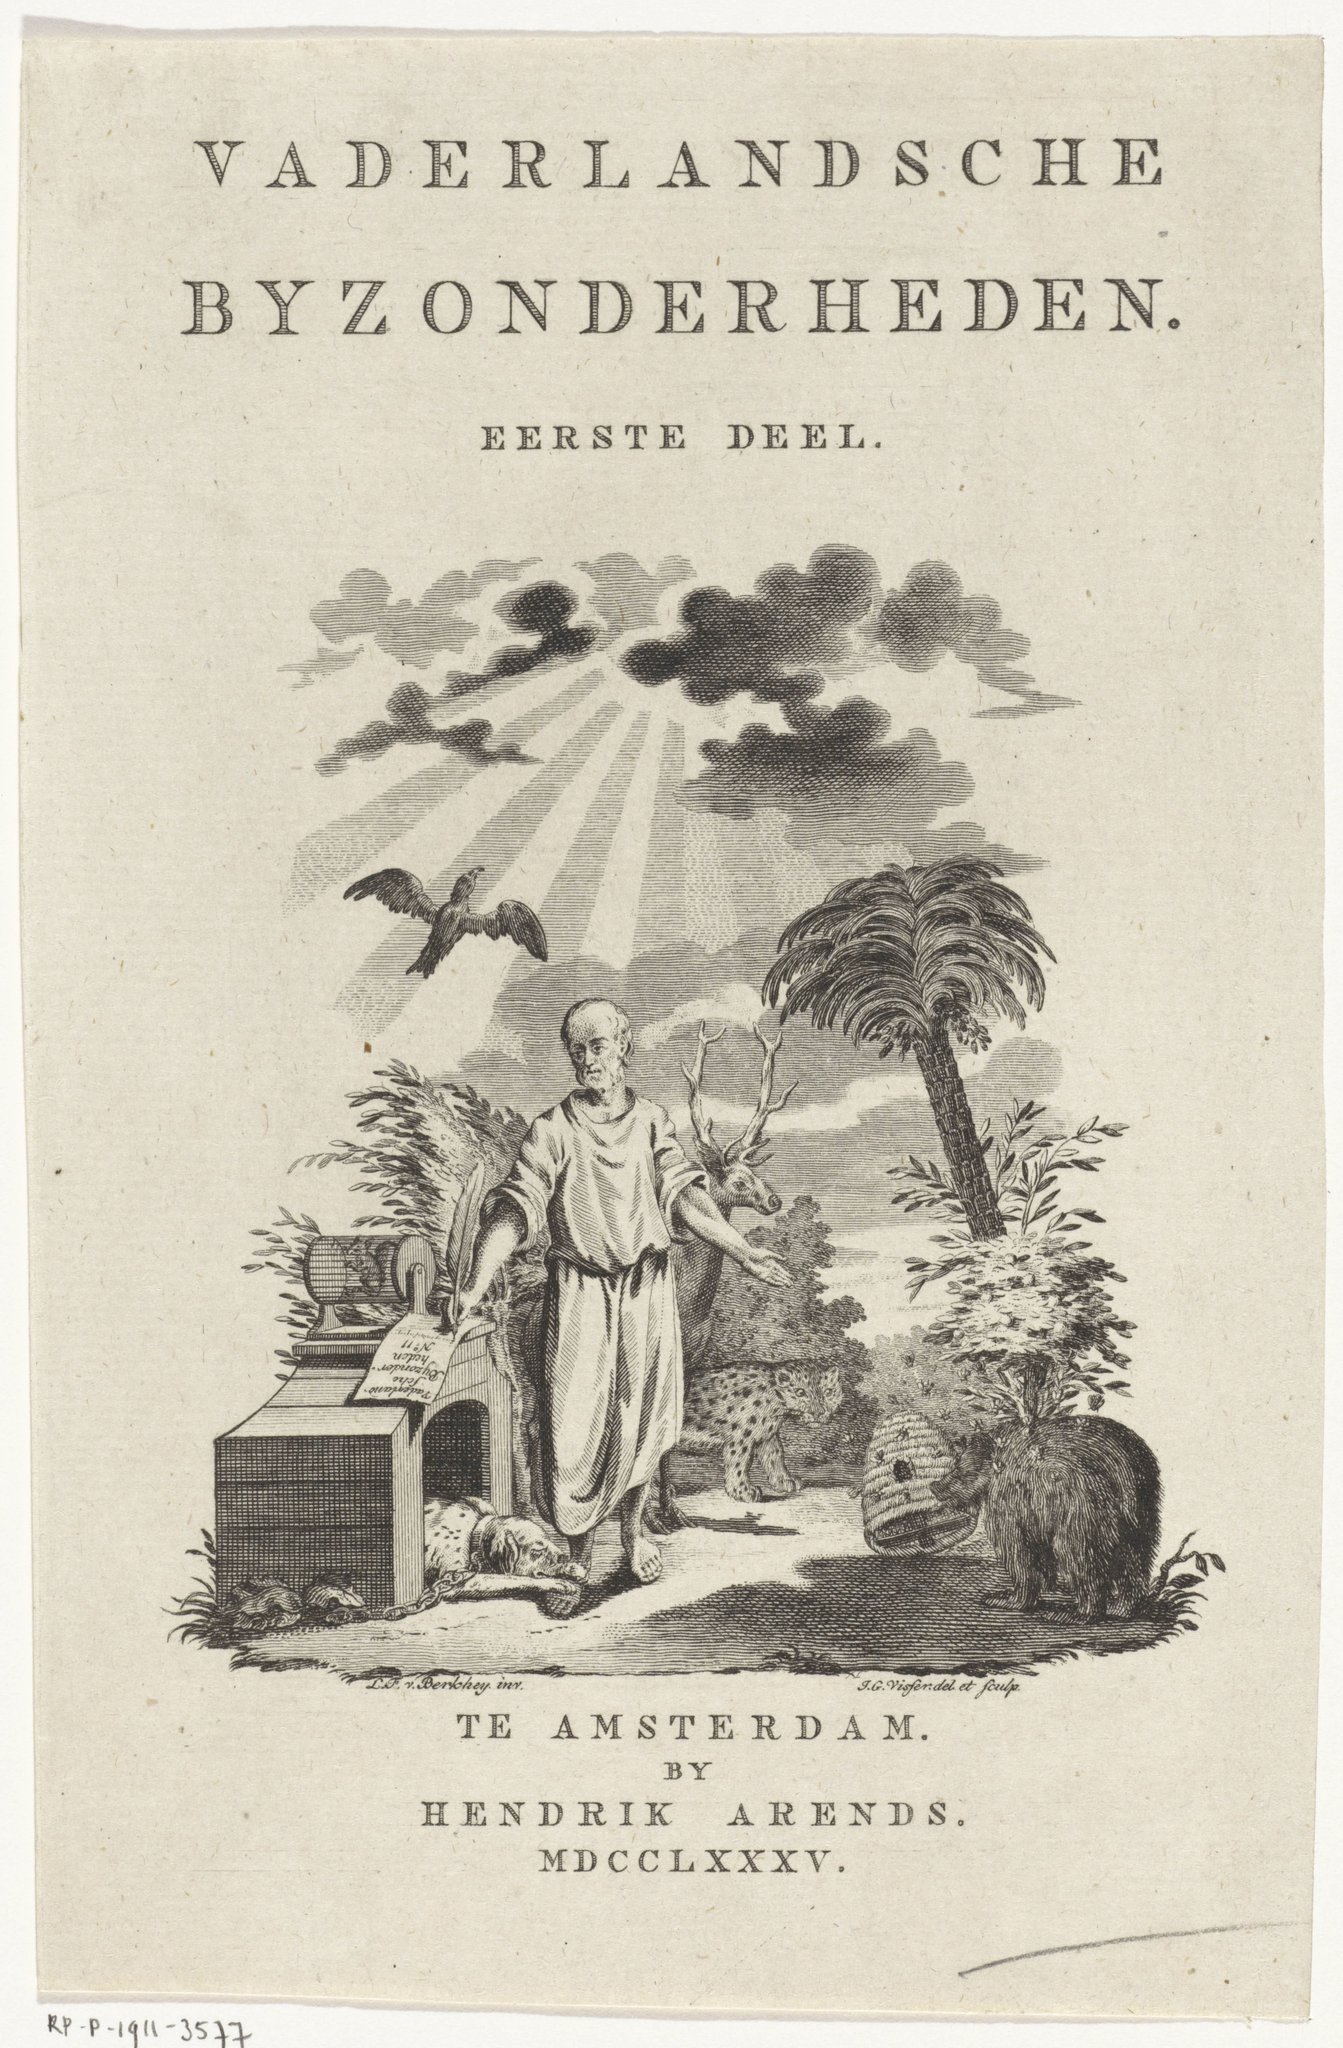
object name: titelblad, titelpagina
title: Man met schrijfveer tussen dieren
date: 1785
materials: paper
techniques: engraving, etching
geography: amsterdam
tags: beasts of prey, predatory animals: leopard, hoofed animals: deer, quill, beasts of prey, predatory animals: bear, bee-hive, rodents: squirrel, dog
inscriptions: collector's mark: Lugt 2228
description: Een man schrijft met een schrijfveer op een vel papier, terwijl hij tussEn verschillende dieren staat. Rechts een beer bij een bijnekorf, op de achteRgrond een luipaard en een hert en links van hem een slapende hond in een hok en een eekhoorn in een looprad. In de lucht een vogel bj de stralen van de zon.